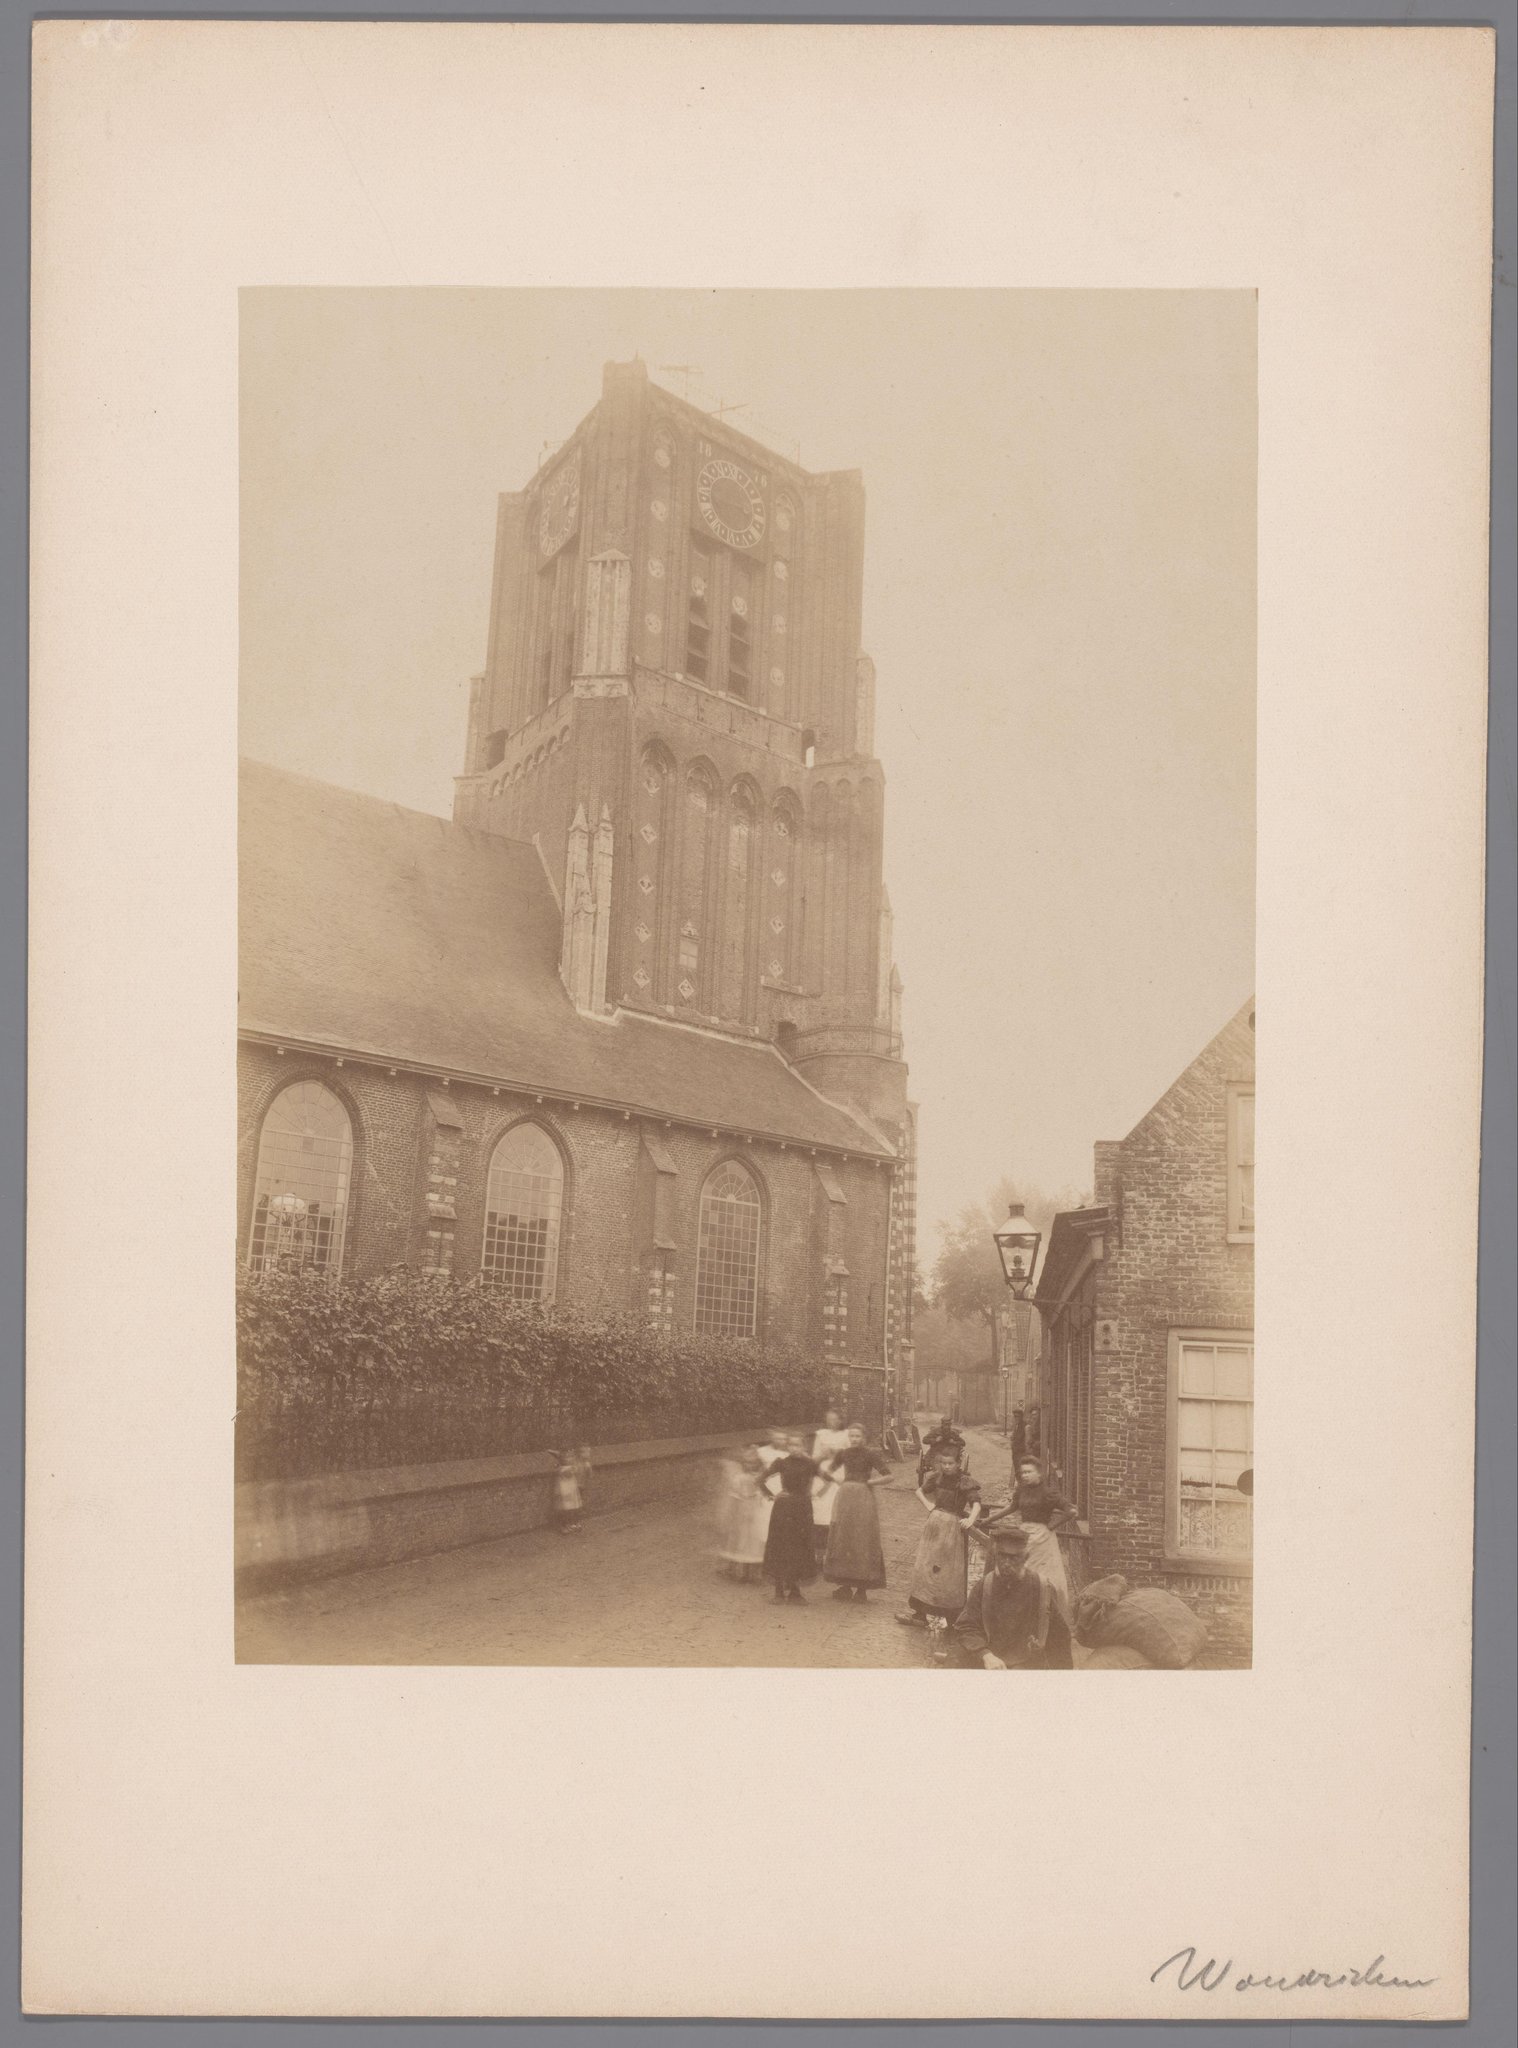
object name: photograph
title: Toren van de Sint-Martinuskerk te Woudrichem, met toekijkende mensen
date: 1901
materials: cardboard, photographic support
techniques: albumen print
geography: woudrichem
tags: street (+ city(-scape) with figures, staffage), parts of church exterior and annexes: tower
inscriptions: annotation: ‘Woudrichem’, annotation: ‘Woudrichem (N.B.)/ N.O. zijde v/d toren/ oct 1901/ NB W-Z’